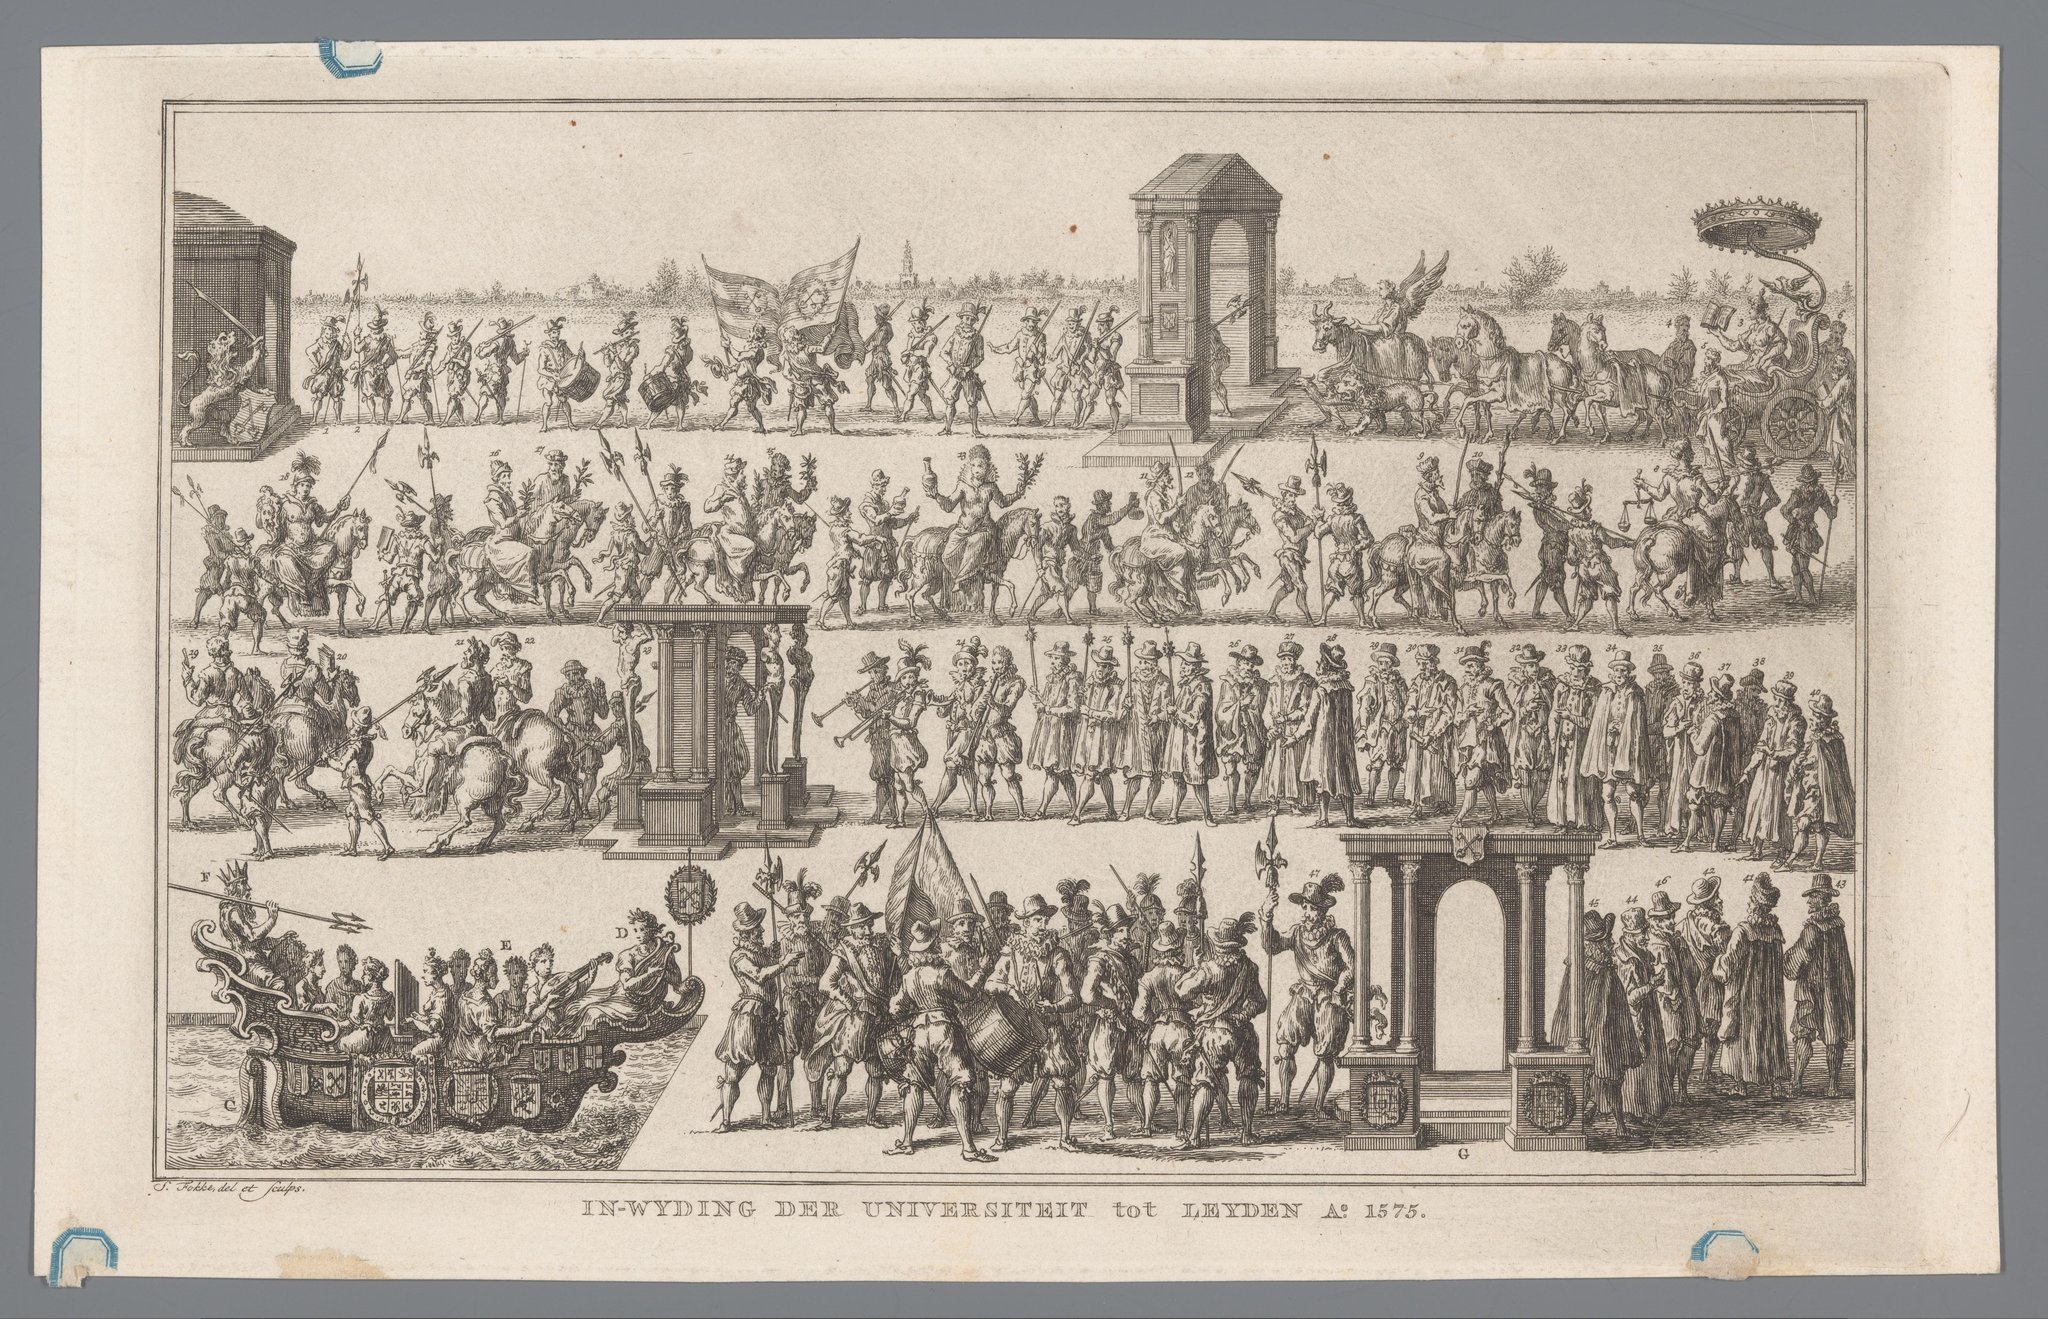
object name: print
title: In-wyding der universiteit tot Leyden Ao. 1575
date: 1752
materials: paper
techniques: etching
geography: amsterdam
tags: festivities (+ parade, pageant, cavalcade ~ festive activities), founding of a university, leiden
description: Optocht bij de inwijding van Universiteit van Leiden, 8 februari 1575. Stoet in vier rijen boven elkaar afgebeeld. Linksonder het schip met Apollo, Neptunus en de negen muzen. Verder soldaten, muzikanten, allegorische figuren die de wetenschappen verbeelden, hoogwaardigheidsbekleders, stadsboden en professoren. Figuren en onderdelen in de voorstelling zijn aangeduid met cijfers en letters.